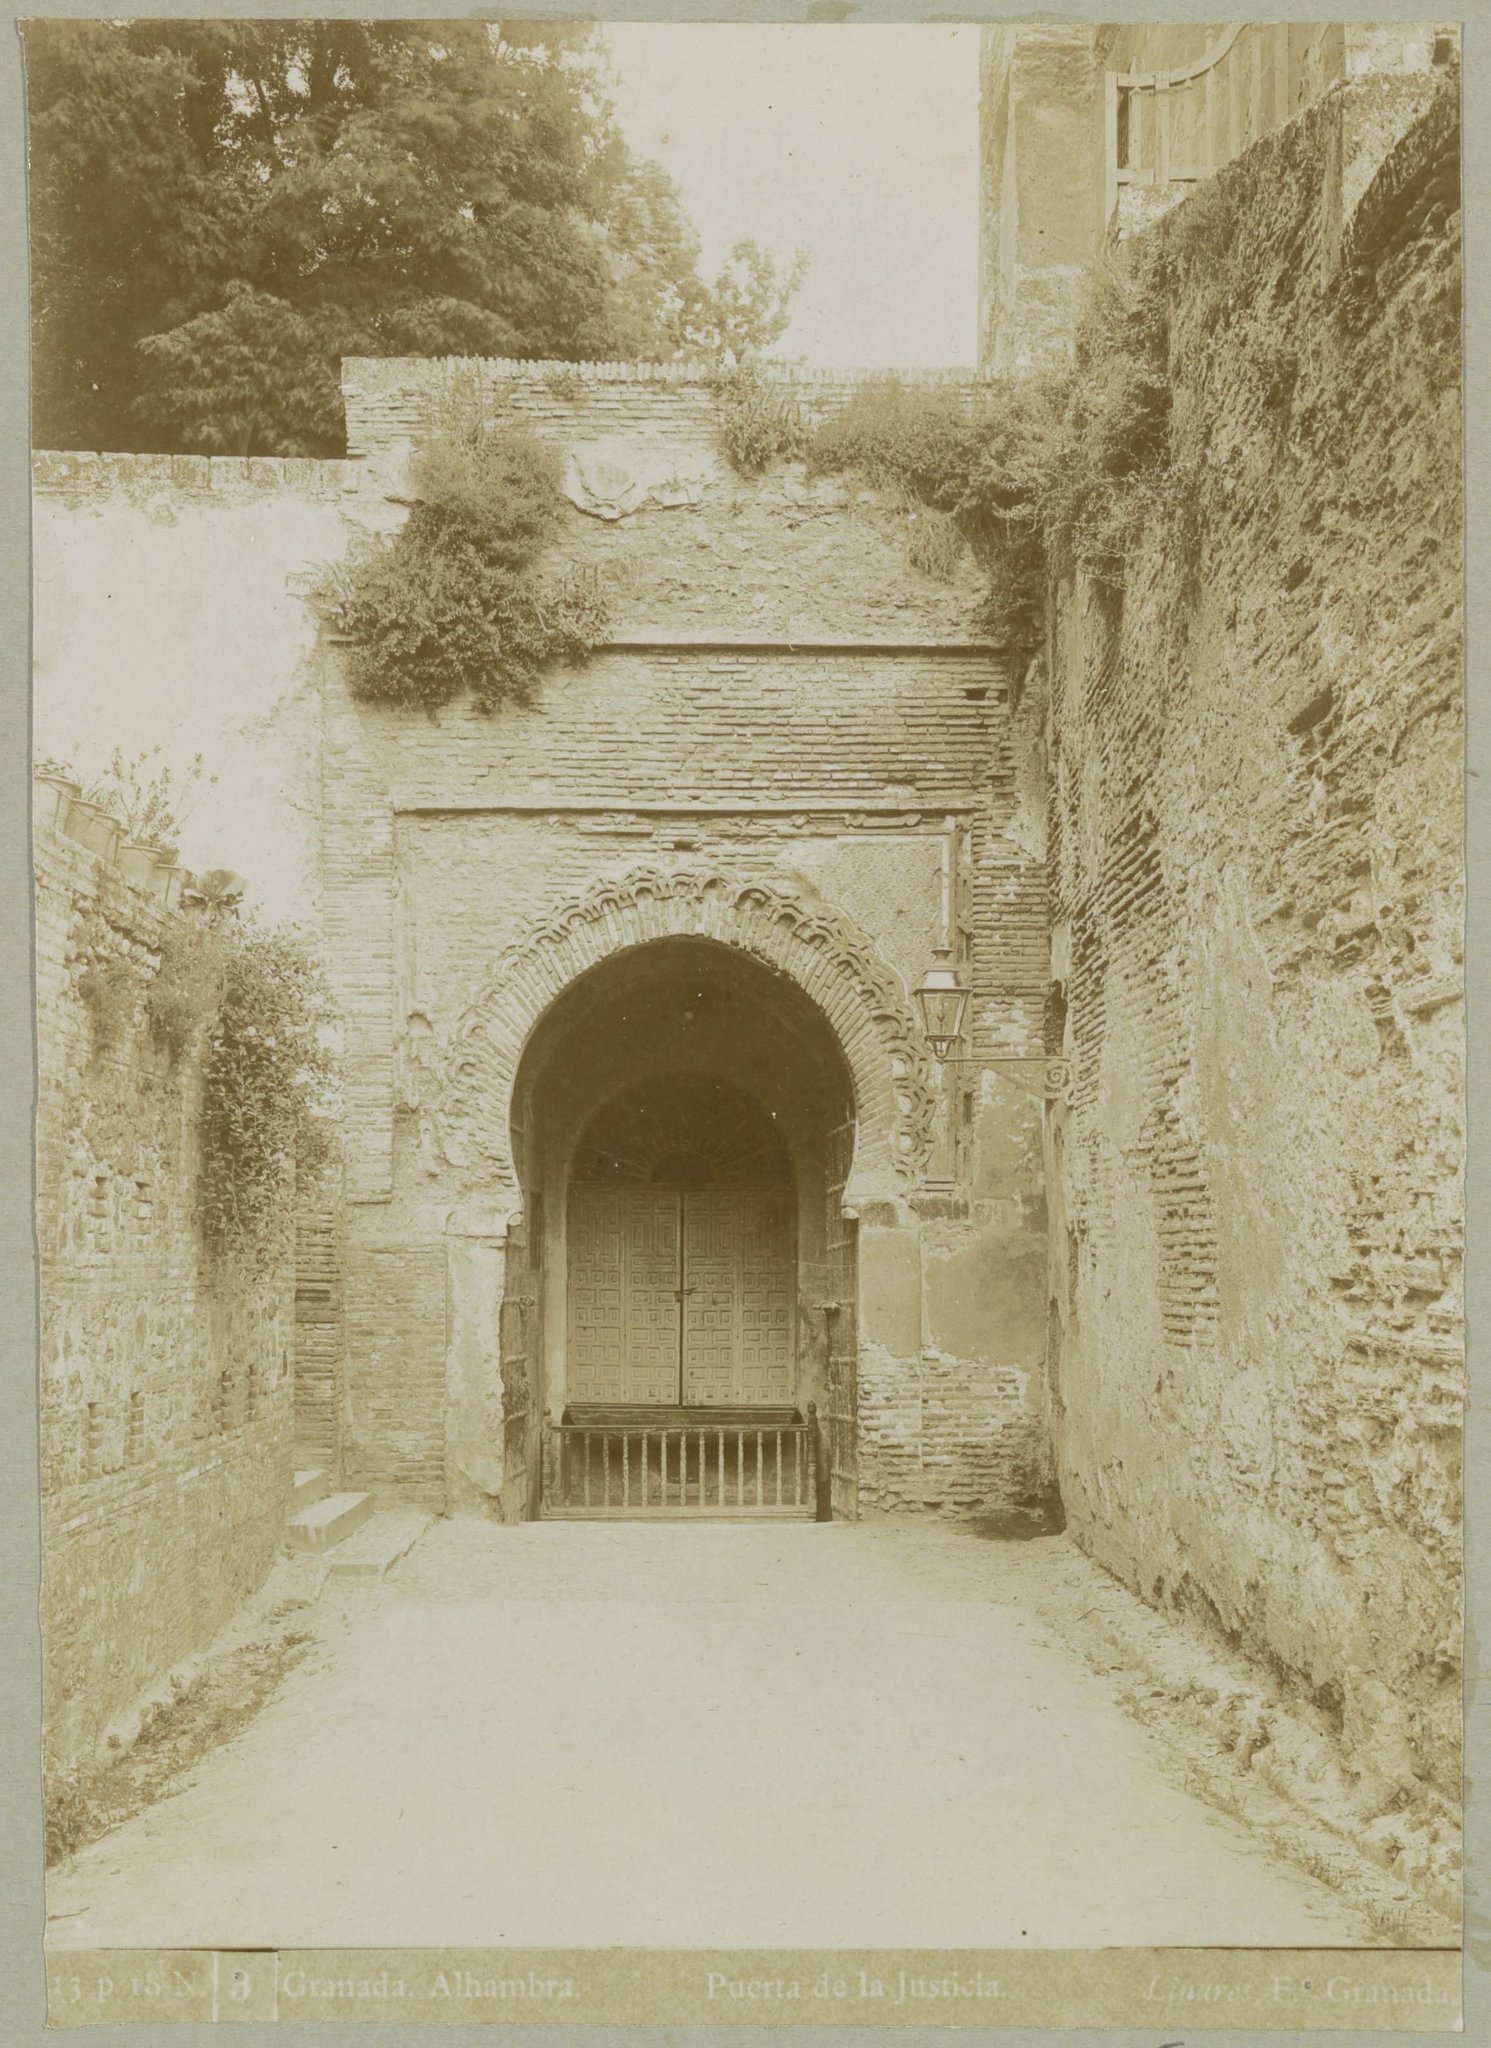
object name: photograph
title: Puerta de la Justicia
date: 1860-1900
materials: photographic support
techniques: daylight paper print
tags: fortress, palace, gate, entrance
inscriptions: number: ‘3’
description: Onderdeel van Reisalbum met opnames van het Alhambra in Granada.